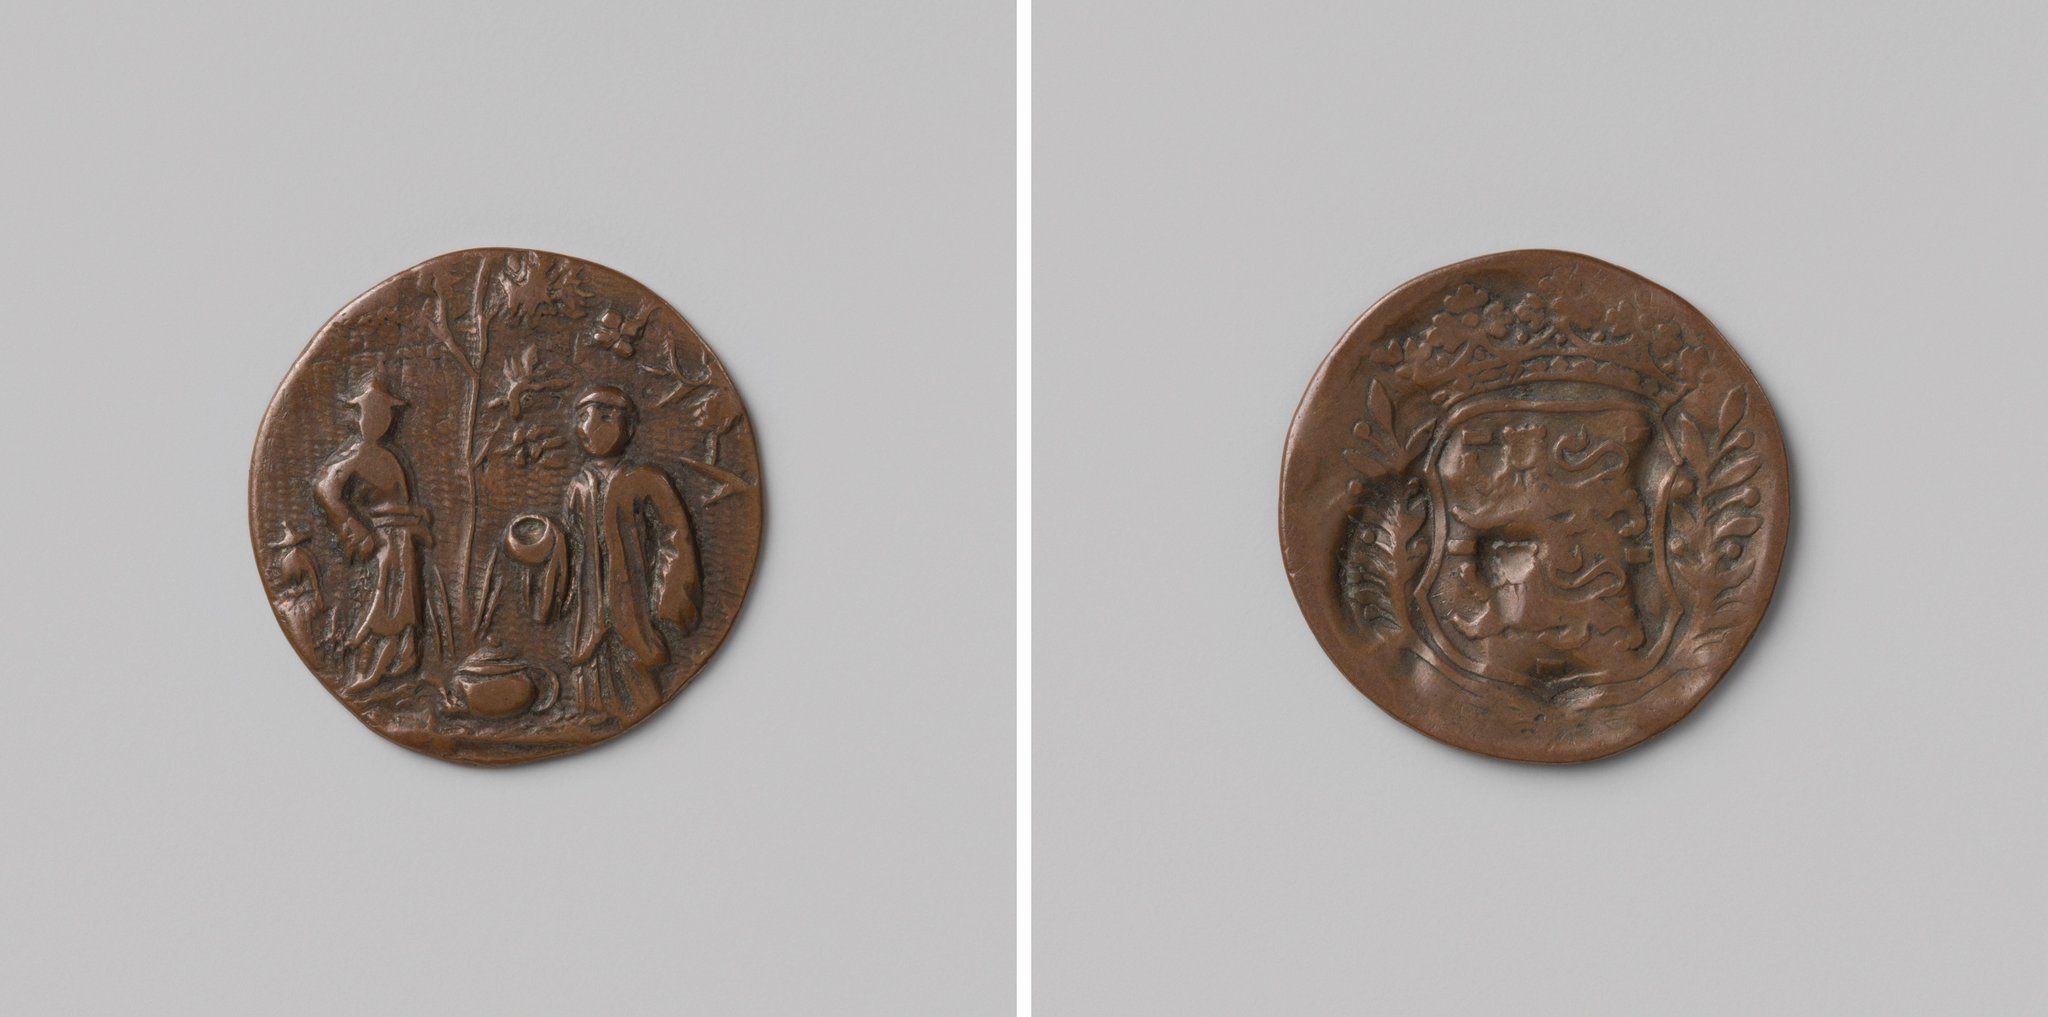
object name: duit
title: Penning met Chinese voorstelling, vervaardigd uit een duit van West-Friesland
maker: Anonymous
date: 1702-1780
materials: copper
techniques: striking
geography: west frisia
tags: west-friesland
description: Koperen penning. Voorzijde: twee mannen in Chinese kledij, staande in tuin, waarbij rechter een kleine schotel in hand houdt. Keerzijde: gekroond wapenschild, rustend op twee lauwertakken